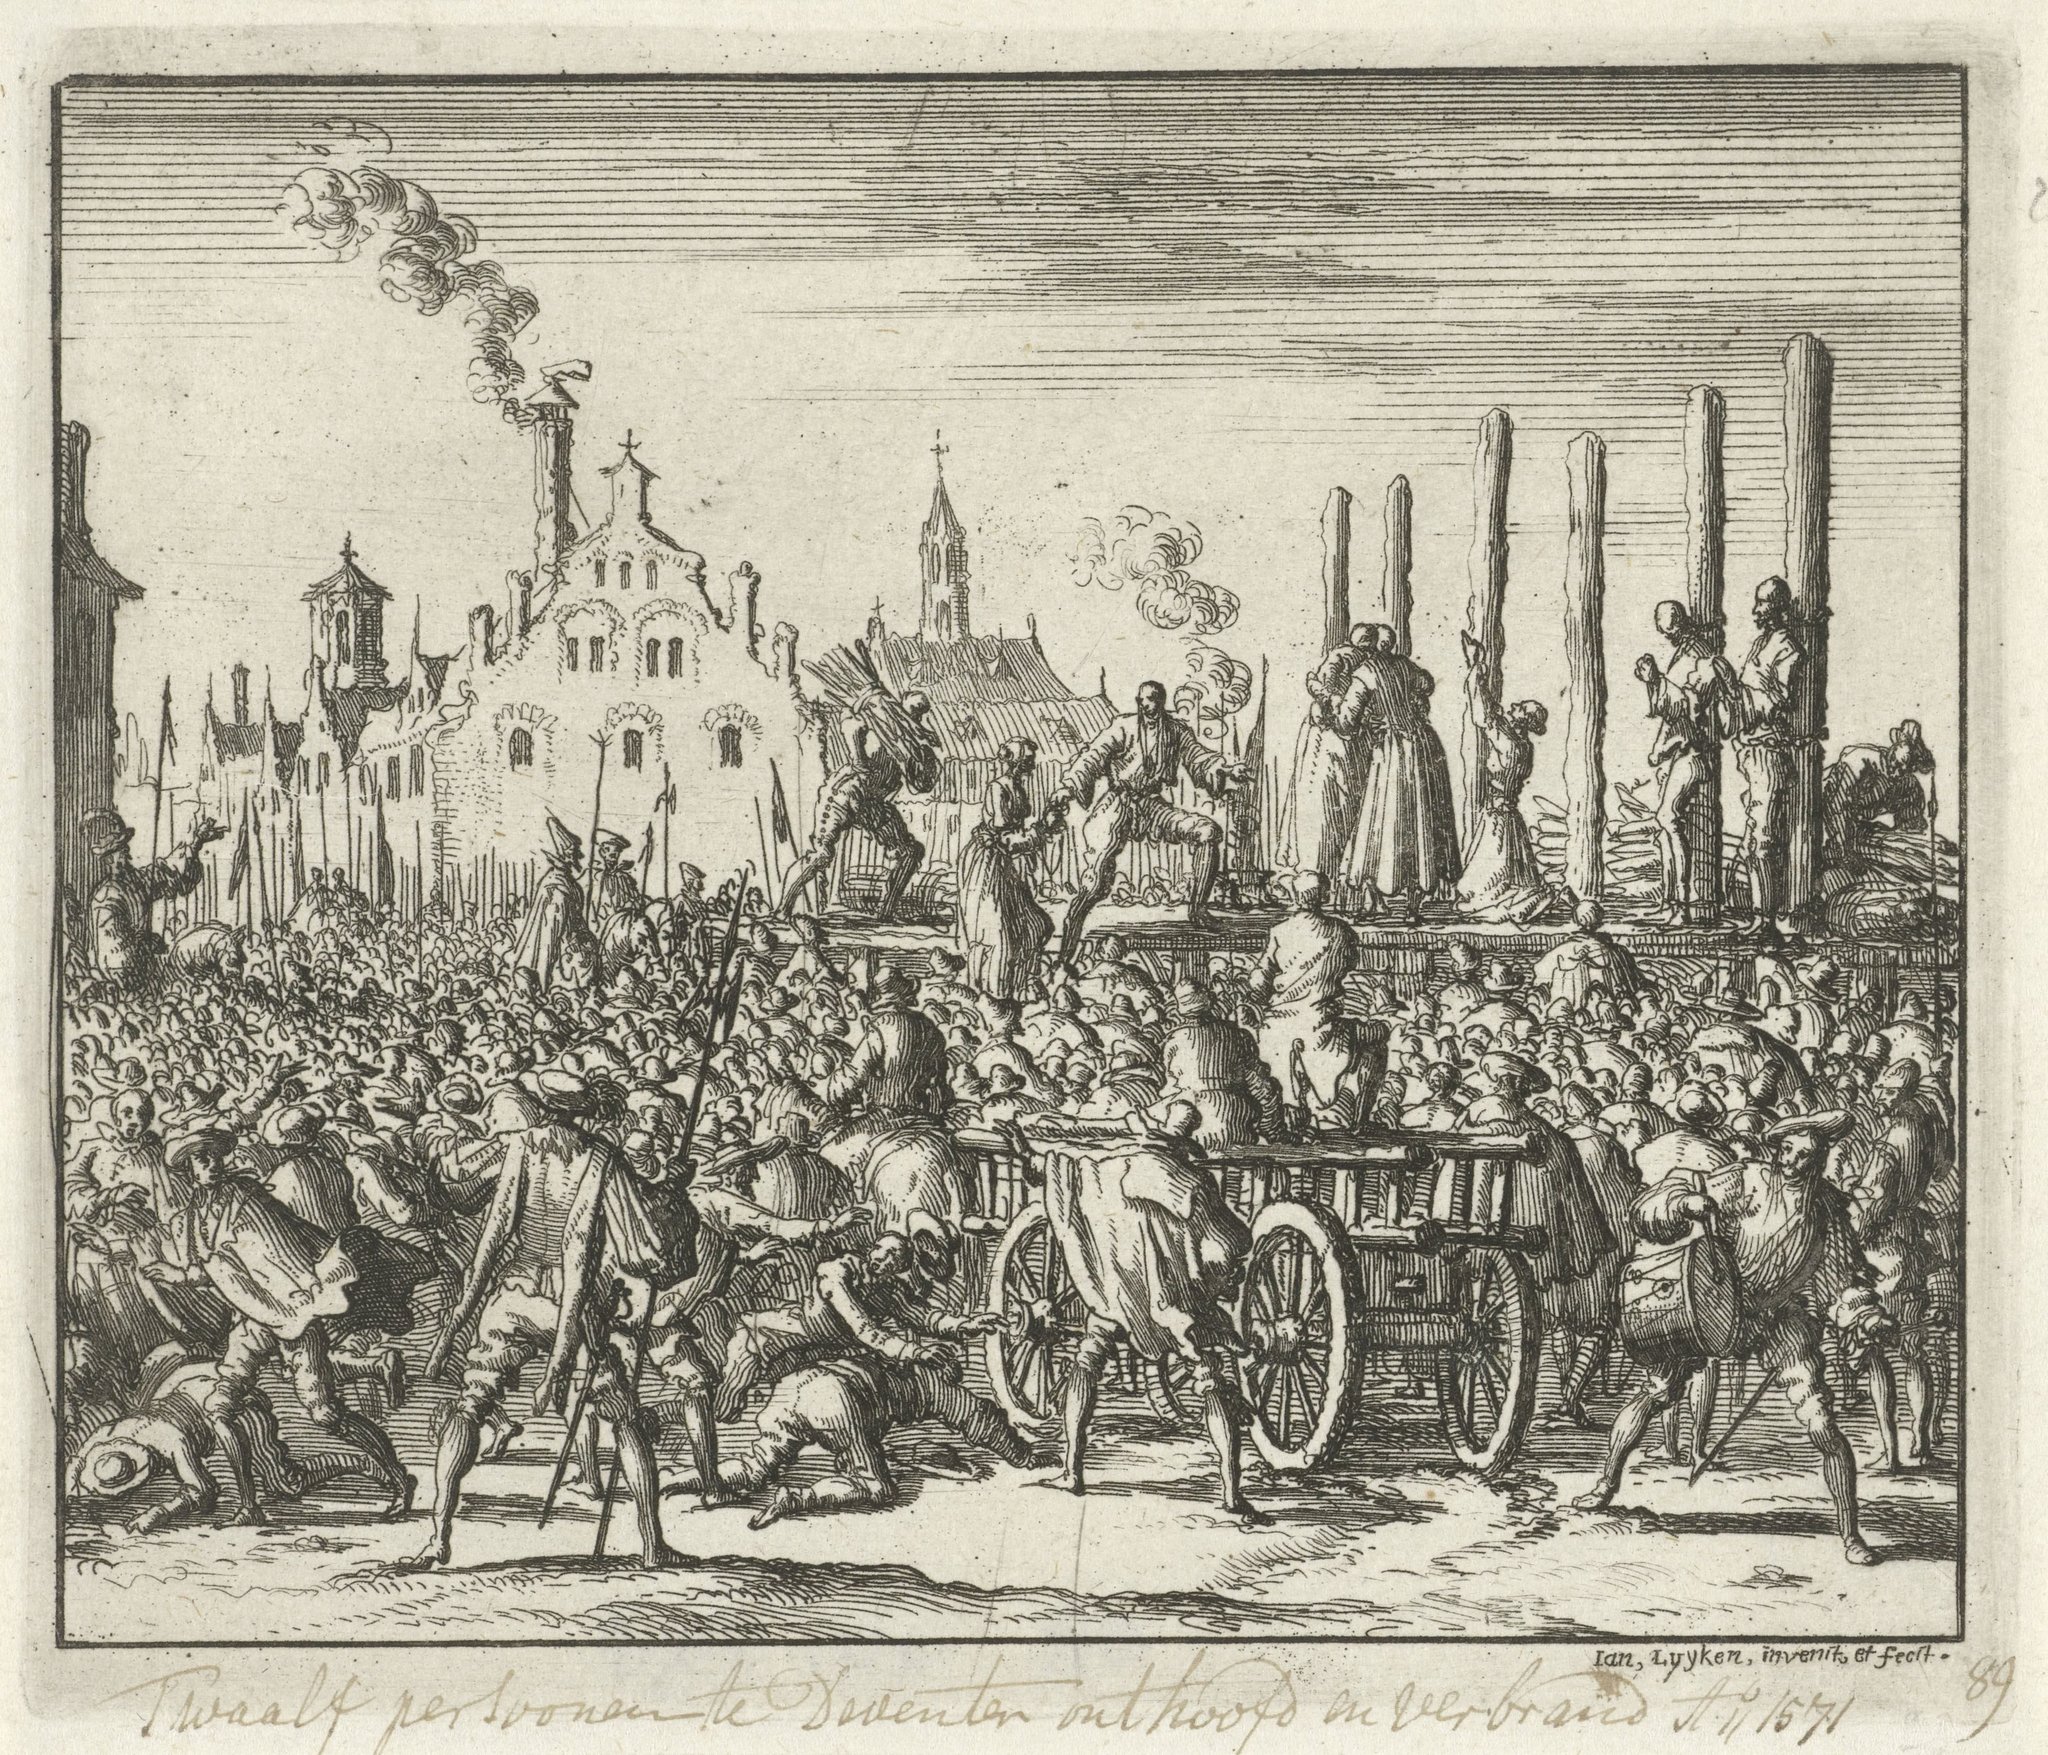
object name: print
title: Harmen de Verwer en vijf anderen te Deventer verbrand, 1571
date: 1685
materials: paper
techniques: etching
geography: amsterdam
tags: execution of heretic, e.g. by burning at the stake, 'auto-da-fé', violent death by burning at the stake; pyre, deventer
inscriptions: collector's mark: Lugt 2228, inscription: ‘Twaalf persoonen [...] Ao 1571’, number: ‘89’